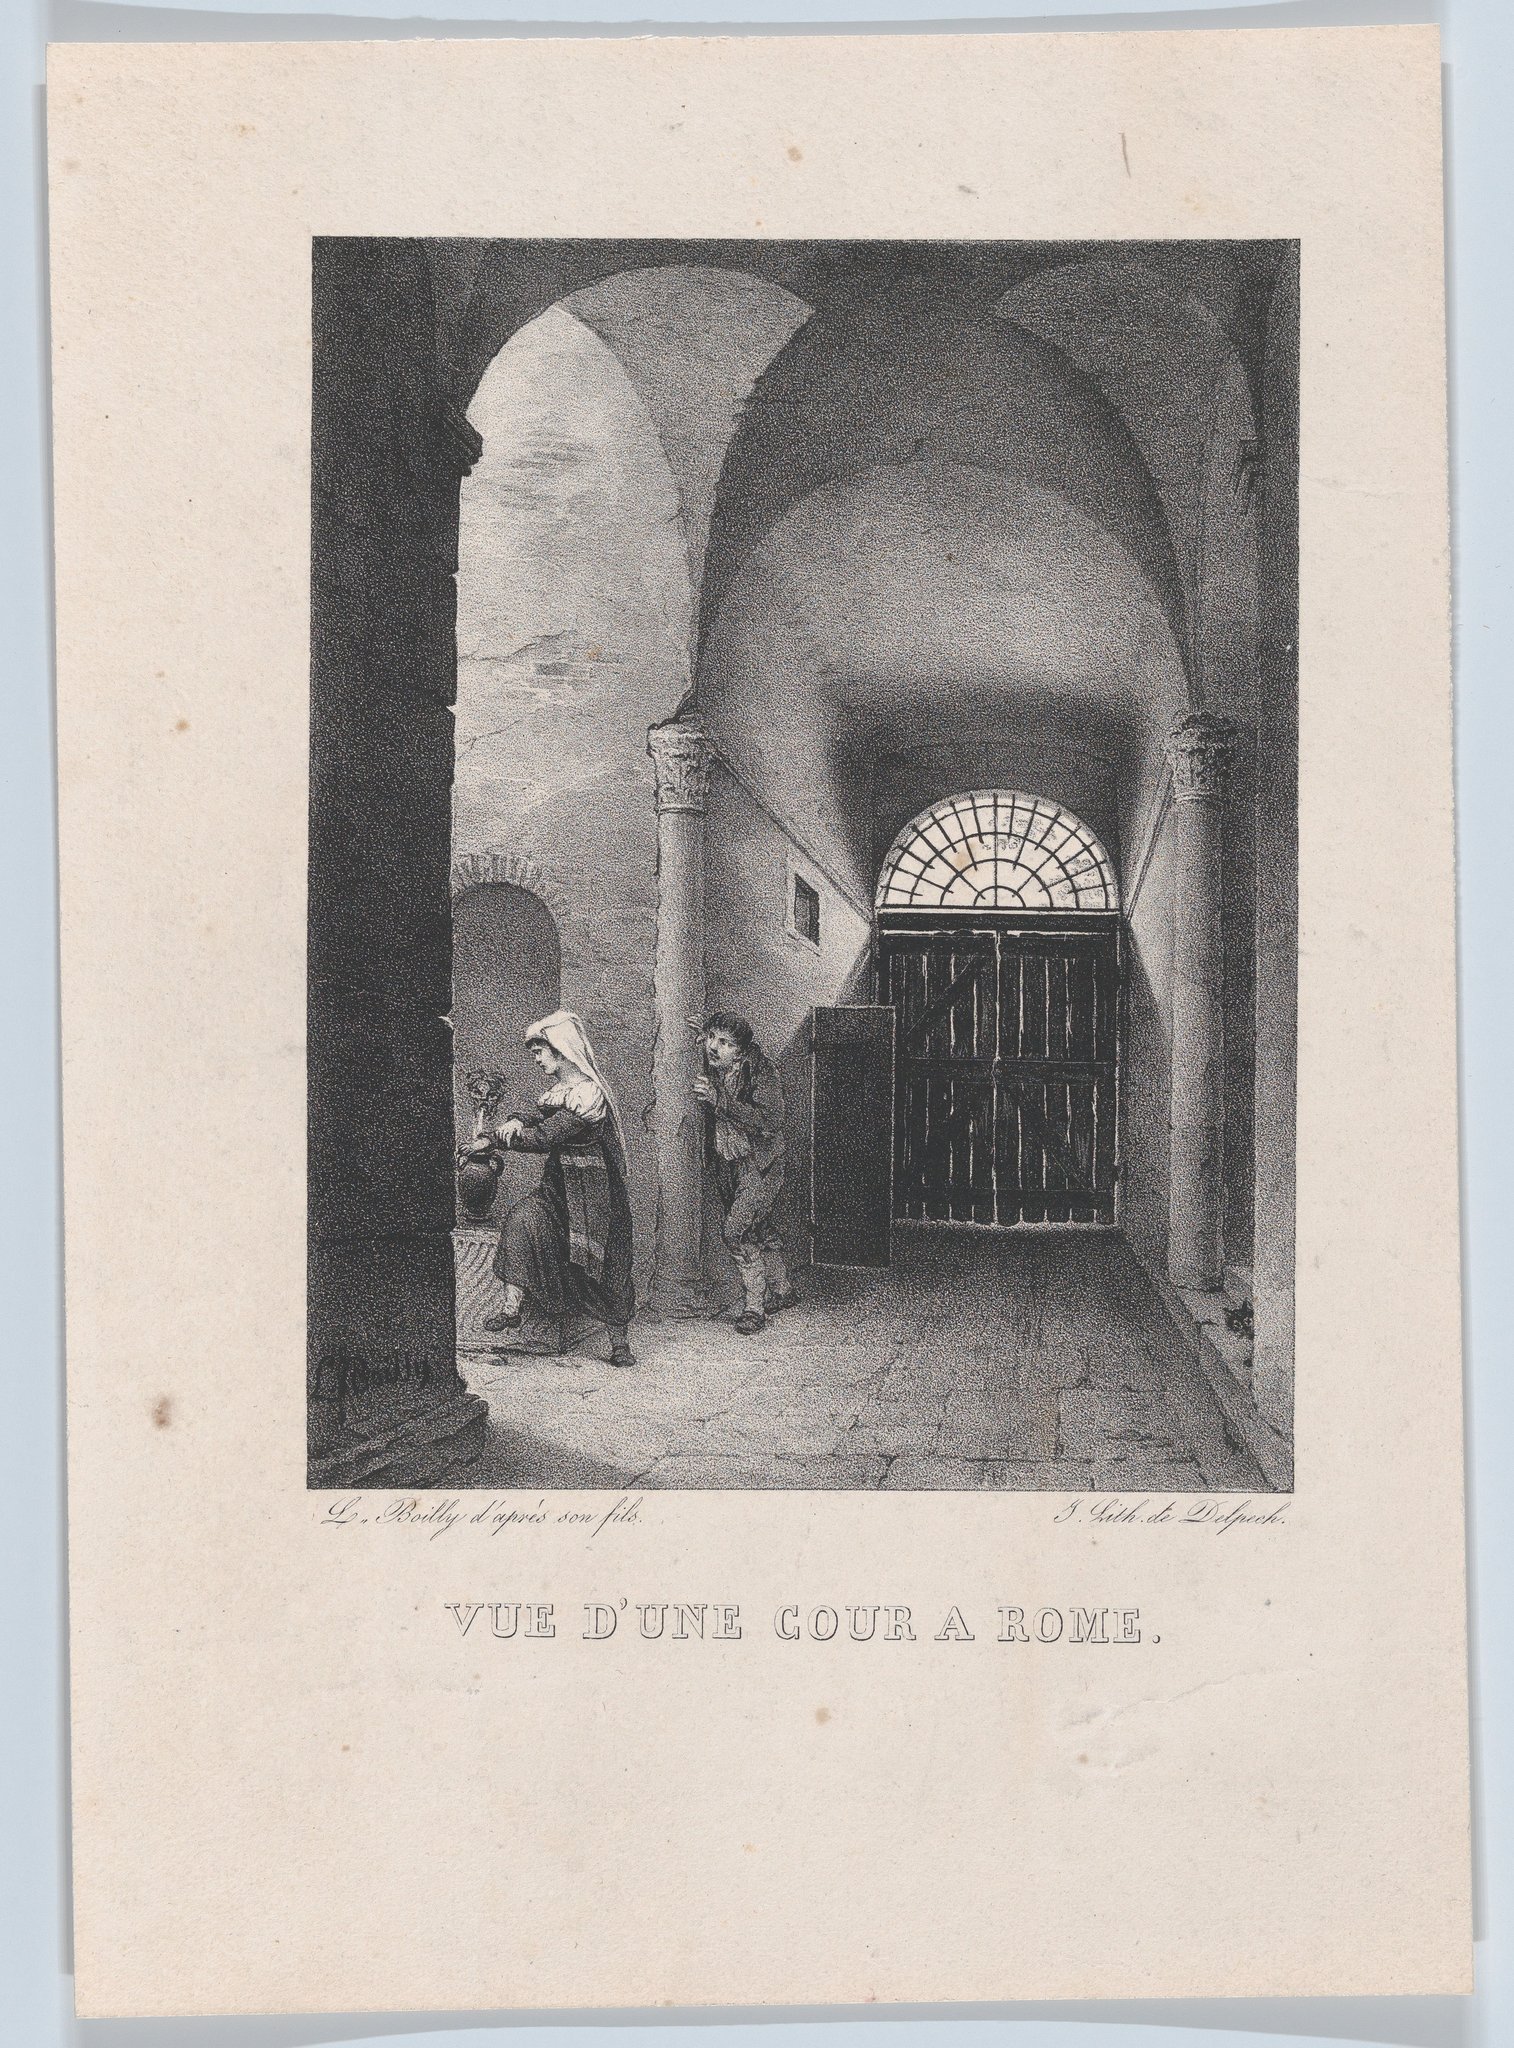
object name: print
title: View of a Courtyard in Rome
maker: louis léopold boilly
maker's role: artist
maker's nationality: french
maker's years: 1761-1845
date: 1826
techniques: lithograph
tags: gates,courtyards,men,women